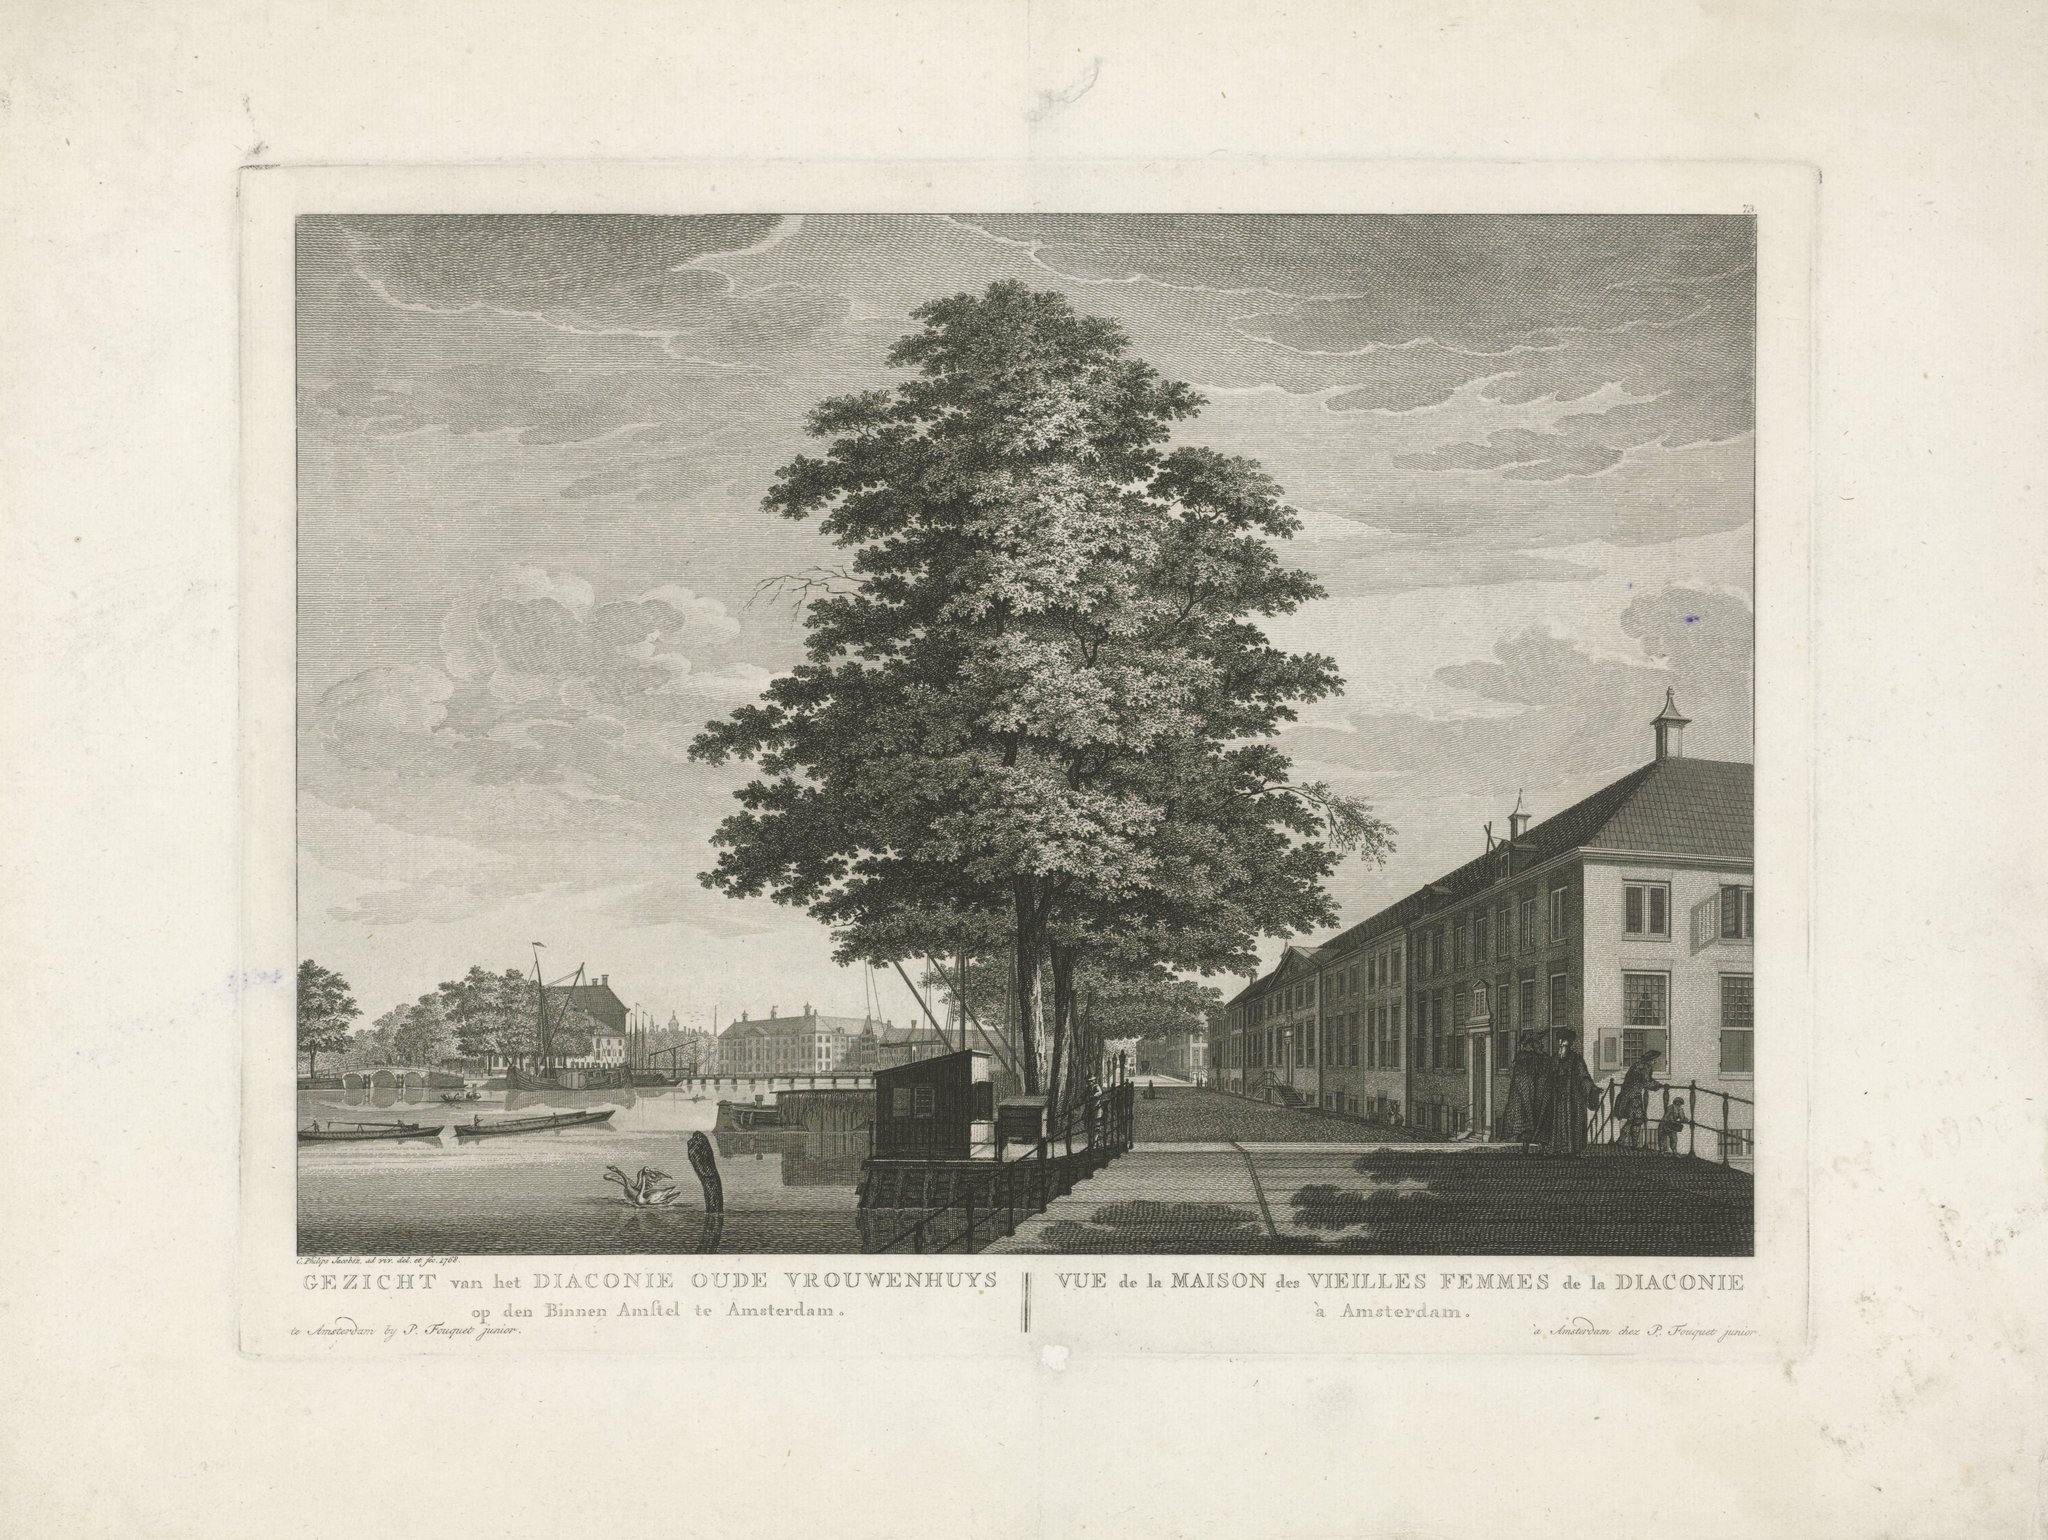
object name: print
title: Gezicht op het Diaconie Oude Vrouwen- en Mannenhuis te Amsterdam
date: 1768-1783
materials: paper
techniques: engraving, etching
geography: amsterdam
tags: bridge in city across river, canal, etc. (+ city(-scape) with figures, staffage), public welfare, orphanage, canals, waters (in city) (+ city(-scape) with figures, staffage), old-people's home, street (+ city(-scape) with figures, staffage)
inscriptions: collector's mark: Lugt 2228, collector's mark: ‘Doublet.’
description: Deze prent is ook gebruikt in de zogenaamde Atlas van Fouquet.* Pierre Fouquet gaf vanaf 1760 stadsgezichten van Amsterdam - naar tekeningen van verschillende kunstenaars, gemaakt door verschillende prentmakers - uit. Deze prenten werden aanvankelijk los of in series verkocht. Zoals toen gebruikelijk kon de koper de prenten zelf laten inbinden. Hiertoe gaf Fouquet tussen 1778 en 1783 een titelblad, plattegrond en inhoudsopgave van de tot dusver 100 uitgegeven prenten uit (1). Gezien de inhoud afhankelijk was van wat de koper had verzameld verschilt de inhoud van de verschillende bewaarde Fouquetatlassen onder deze titel sterk. Ook zijn er exemplaren bekend waar tevens andere prenten aan zijn toegevoegd. Omdat er behoefte bleek aan uitleg bij de platen werd in 1783 een nieuwe versie van de atlas uitgegeven, aangevuld met tekst en twee prenten. De aangegeven volgorde veranderde maar de platen van de al eerder uitgegeven prenten bleven ongewijzigd. Deze uitgave werd in opdracht van Fouquet gedrukt bij Daniël Jean Changuion en Petrus den Hengst (2). Een tiental platen werd bijgewerkt en verscheen, met nieuw impressum, in het vervolg van Wagenaars geschiedenis van Amsterdam, uitgeven door Petrus Conradi en Folkert van der Plaats (3). Een aantal jaar na het overlijden van Fouquet kwam Evert Maaskamp met een nieuwe uitgave van de atlas, met verbeterde tekst en toevoeging van twee prenten. Op alle platen verwijderde hij het oude en liet hij zijn eigen impressum zetten (4). De huidige staat van de prent komt voor in exemplaren van de onder (1) en (2) genoemde werken. * Onder de Atlas van Fouquet of Fouquetatlas verstaan we de hieronder vermelde publicaties (1), (2) en (4). (1). Afbeeldingen van de wyd-vermaarde koopstad Amsterdam benevens des zelvs voornaamste gebouwen en gezigten alle naar het leeven getekend / Receuil des edifices les plus considerables et des plus belles vues, de la fameuse ville d'Amsterdam, dessinées d'après nature. Amsterdam: Pierre Fouquet, 1778-1783. (2). Nieuwe atlas, van de voornaamste gebouwen en gezigten der stad Amsterdam, met derzelver beknopte beschryvingen. 2 delen. Amsterdam: Daniël Jean Changuion en Petrus den Hengst [in opdracht van Pierre Fouquet], 1783. (3). Stijl, Simon. Amsterdam, in zyne geschiedenissen, voorregten, koophandel, gebouwen, kerkenstaat, schoolen, schutterye, gilden en regeeringe, beschreeven. Om te dienen ten vervolge op het werk van Jan Wagenaar (…). 10 delen. Amsterdam en Harlingen: Petrus Conradi en Folkert van der Plaats, 1788-1801. (4). Nieuwe atlas, van de voornaamste gebouwen en gezigten der stad Amsterdam. Met derzelver beknopte beschryvingen. Amsterdam: Evert Maaskamp, 1805. * Het aantal vermelde staten is gebaseerd op het aantal gevonden staten. Mogelijk zijn er meer staten van deze prent. Voor eerste bekende staat zie RP-P-1921-578. Voor tweede bekende staat zie RP-P-1905-577.